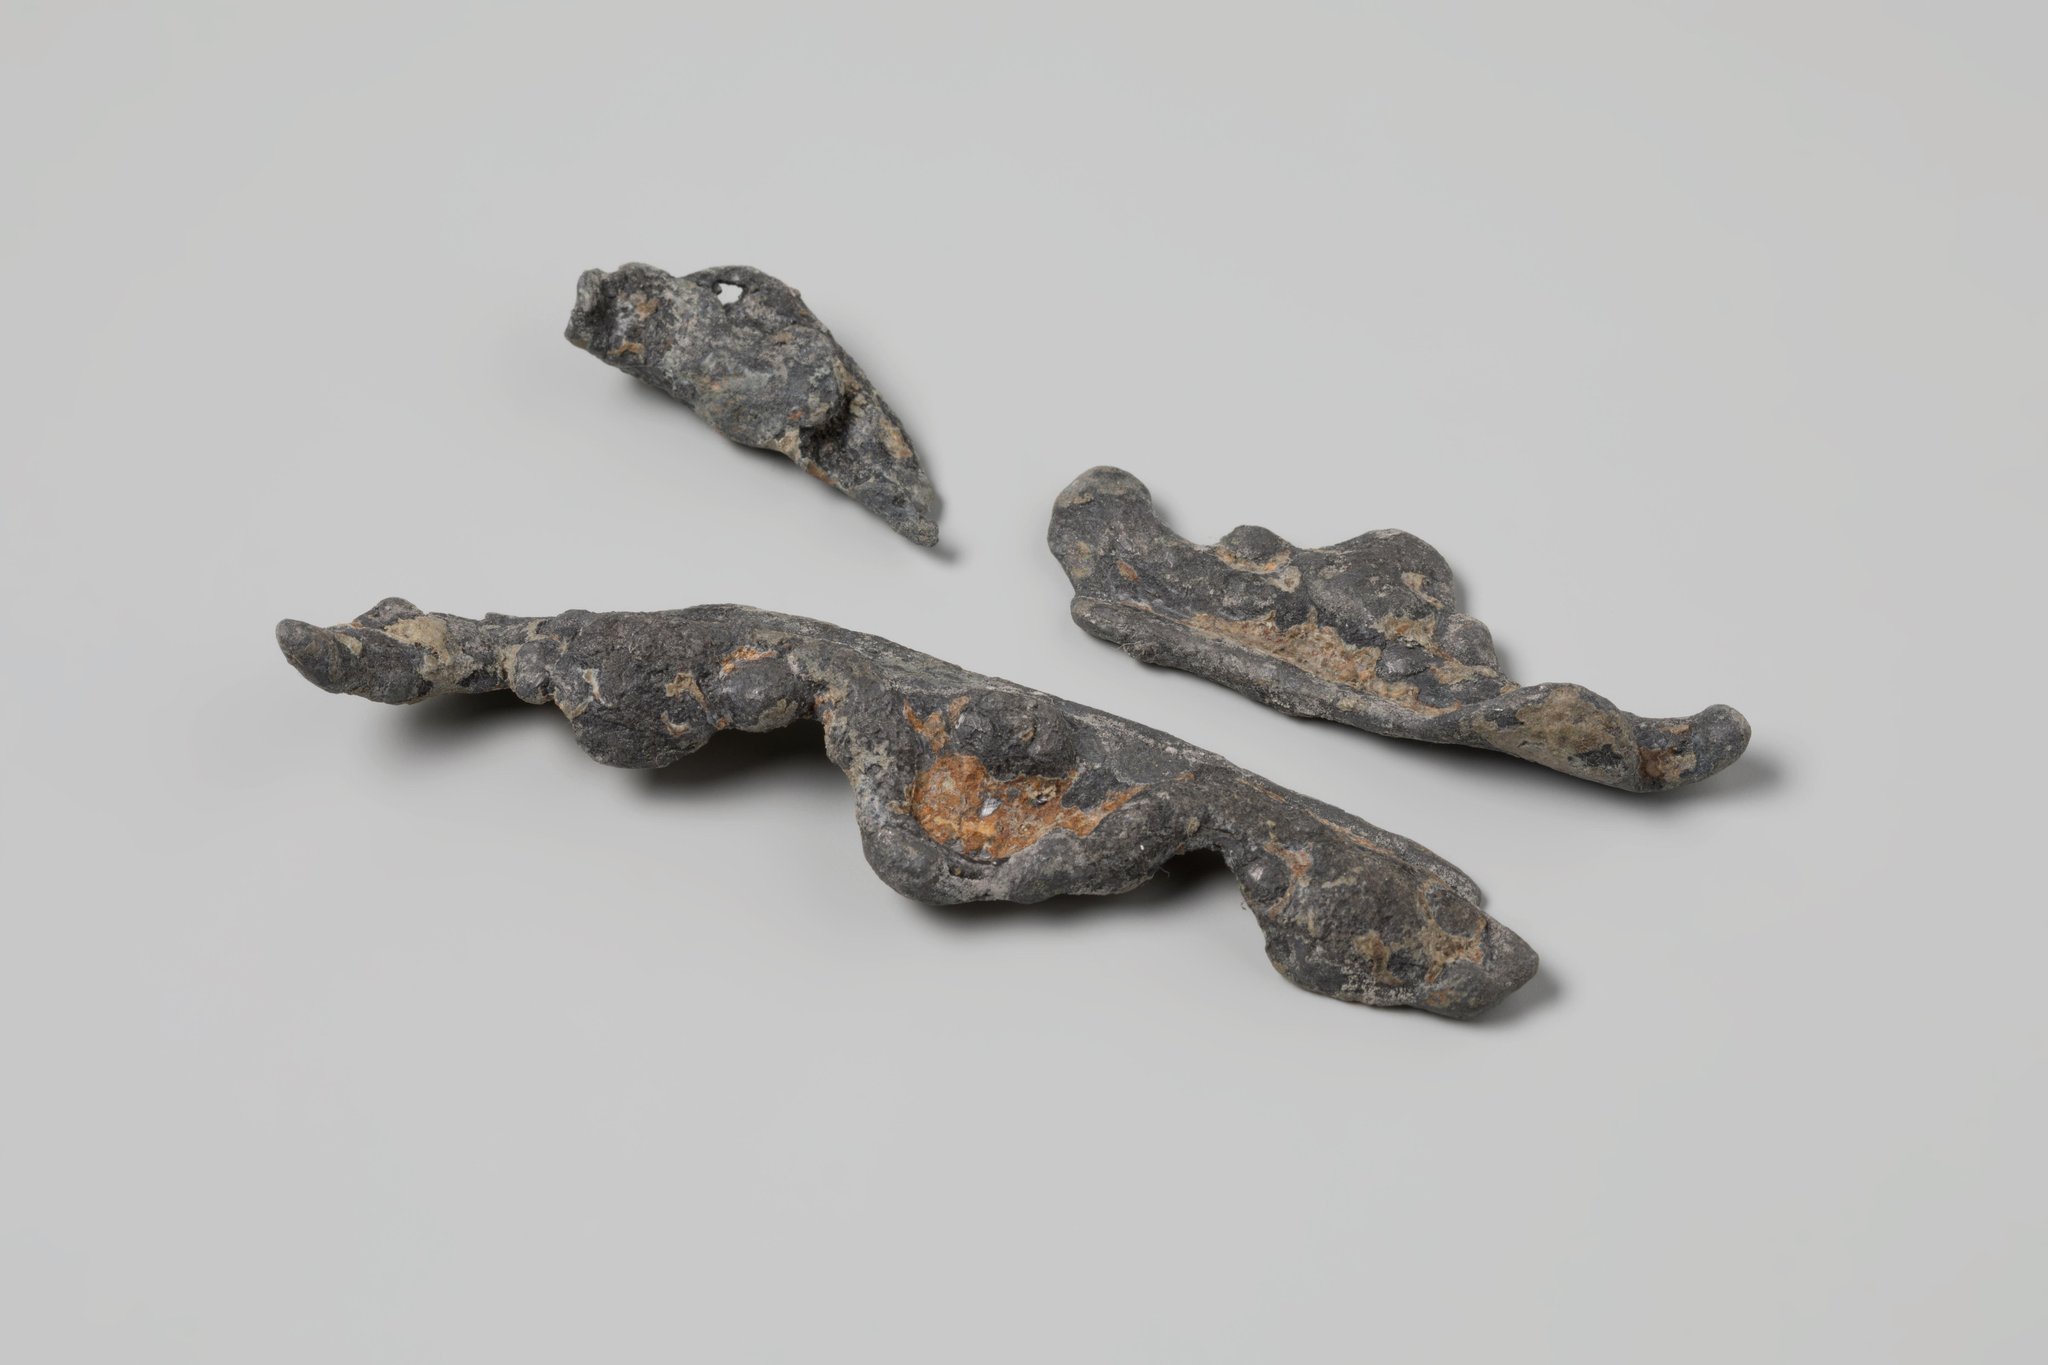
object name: beslag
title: Decoratief beslag uit het wrak van de Oost-Indiëvaarder Hollandia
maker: Anonymous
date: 1700-1743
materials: lead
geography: netherlands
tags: verenigde oostindische compagnie, hollandia (schip), annet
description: Fitting, decorative fitting or fragment; fragm of rim, id. NG 1980-27H139 eroded, squashed.